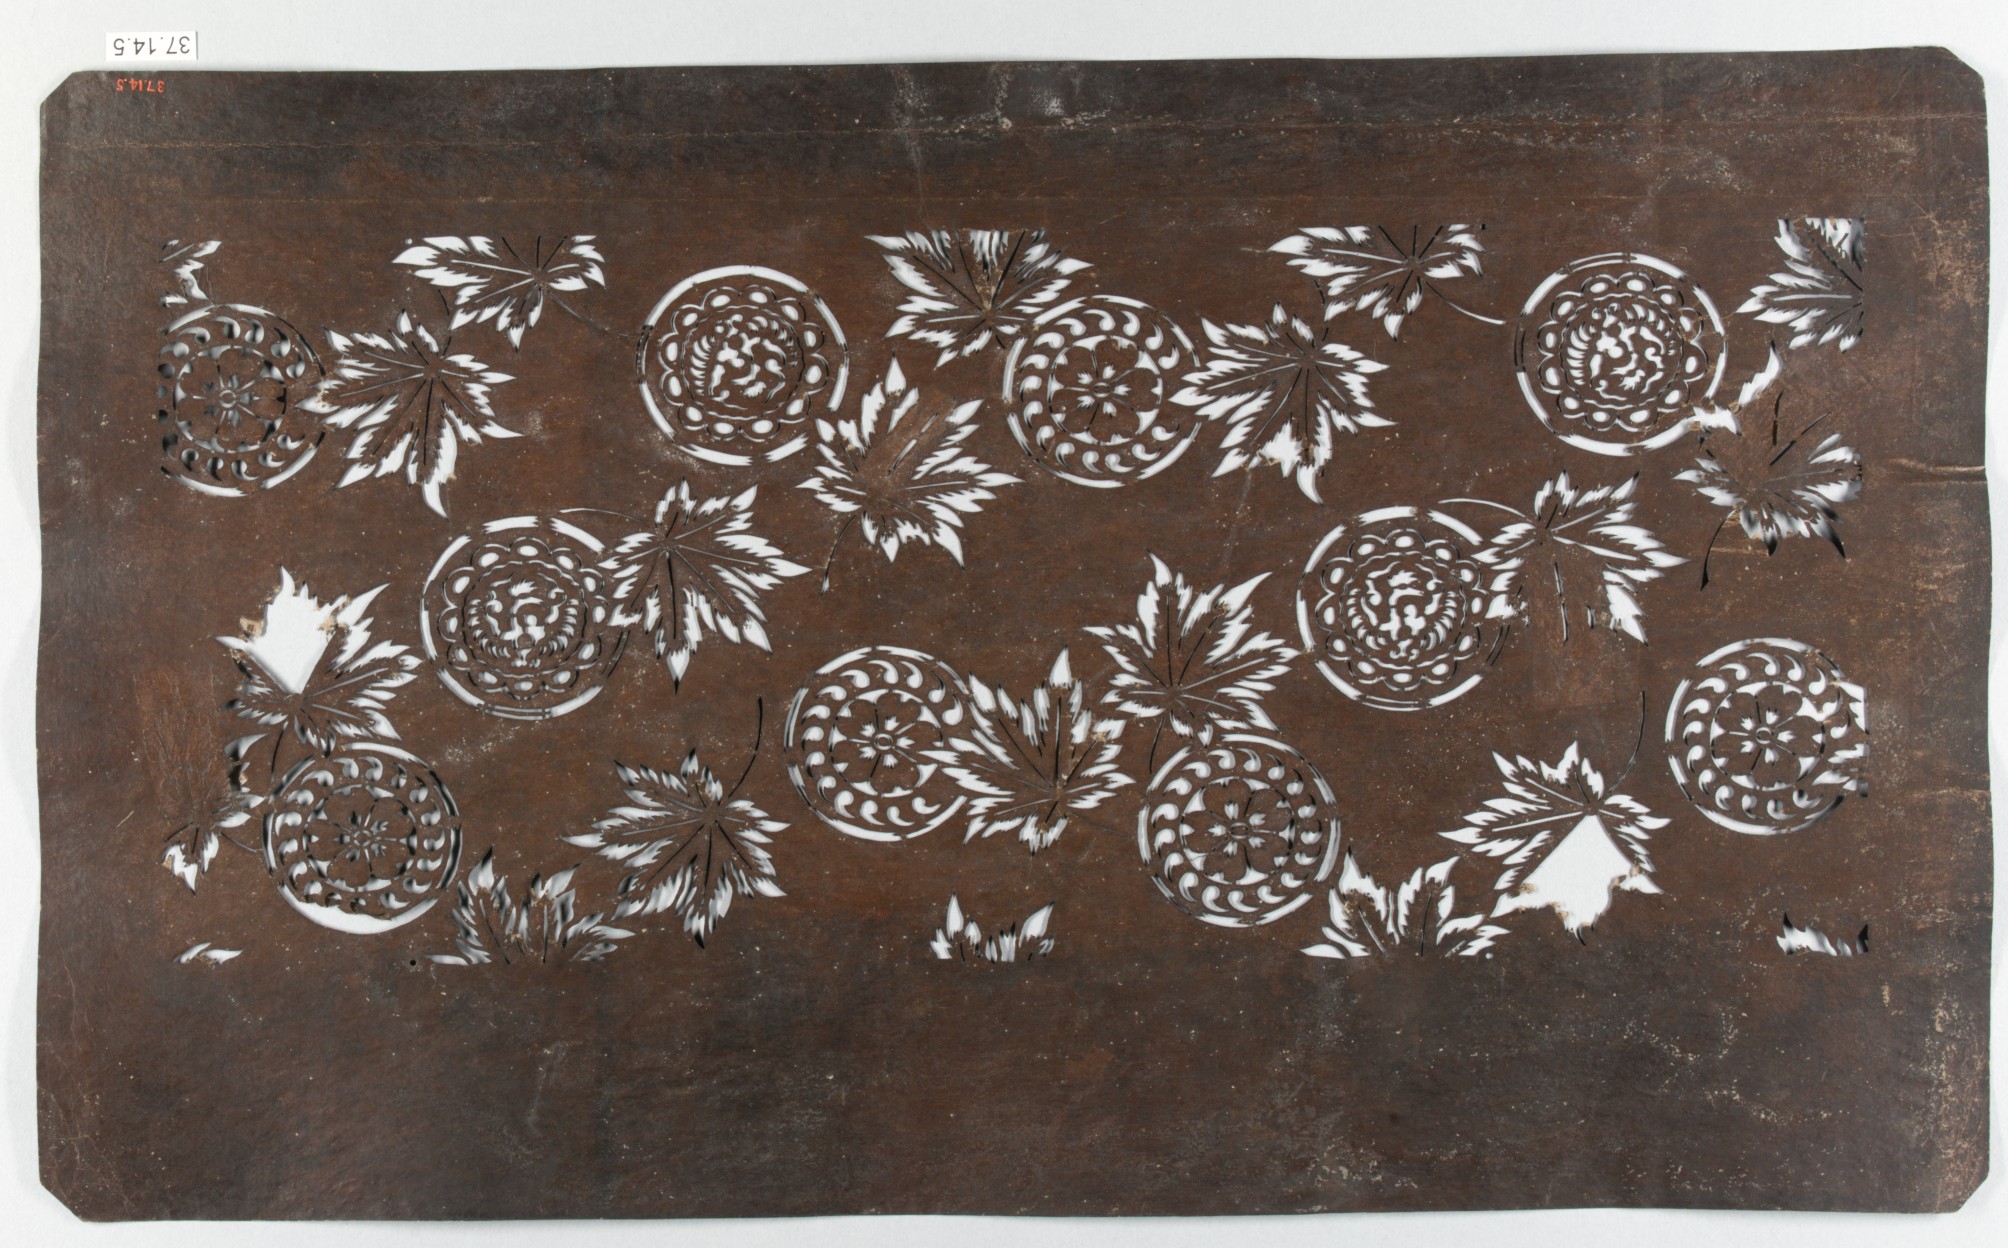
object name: stencil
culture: japanese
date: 1801-1833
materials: paper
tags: leaves